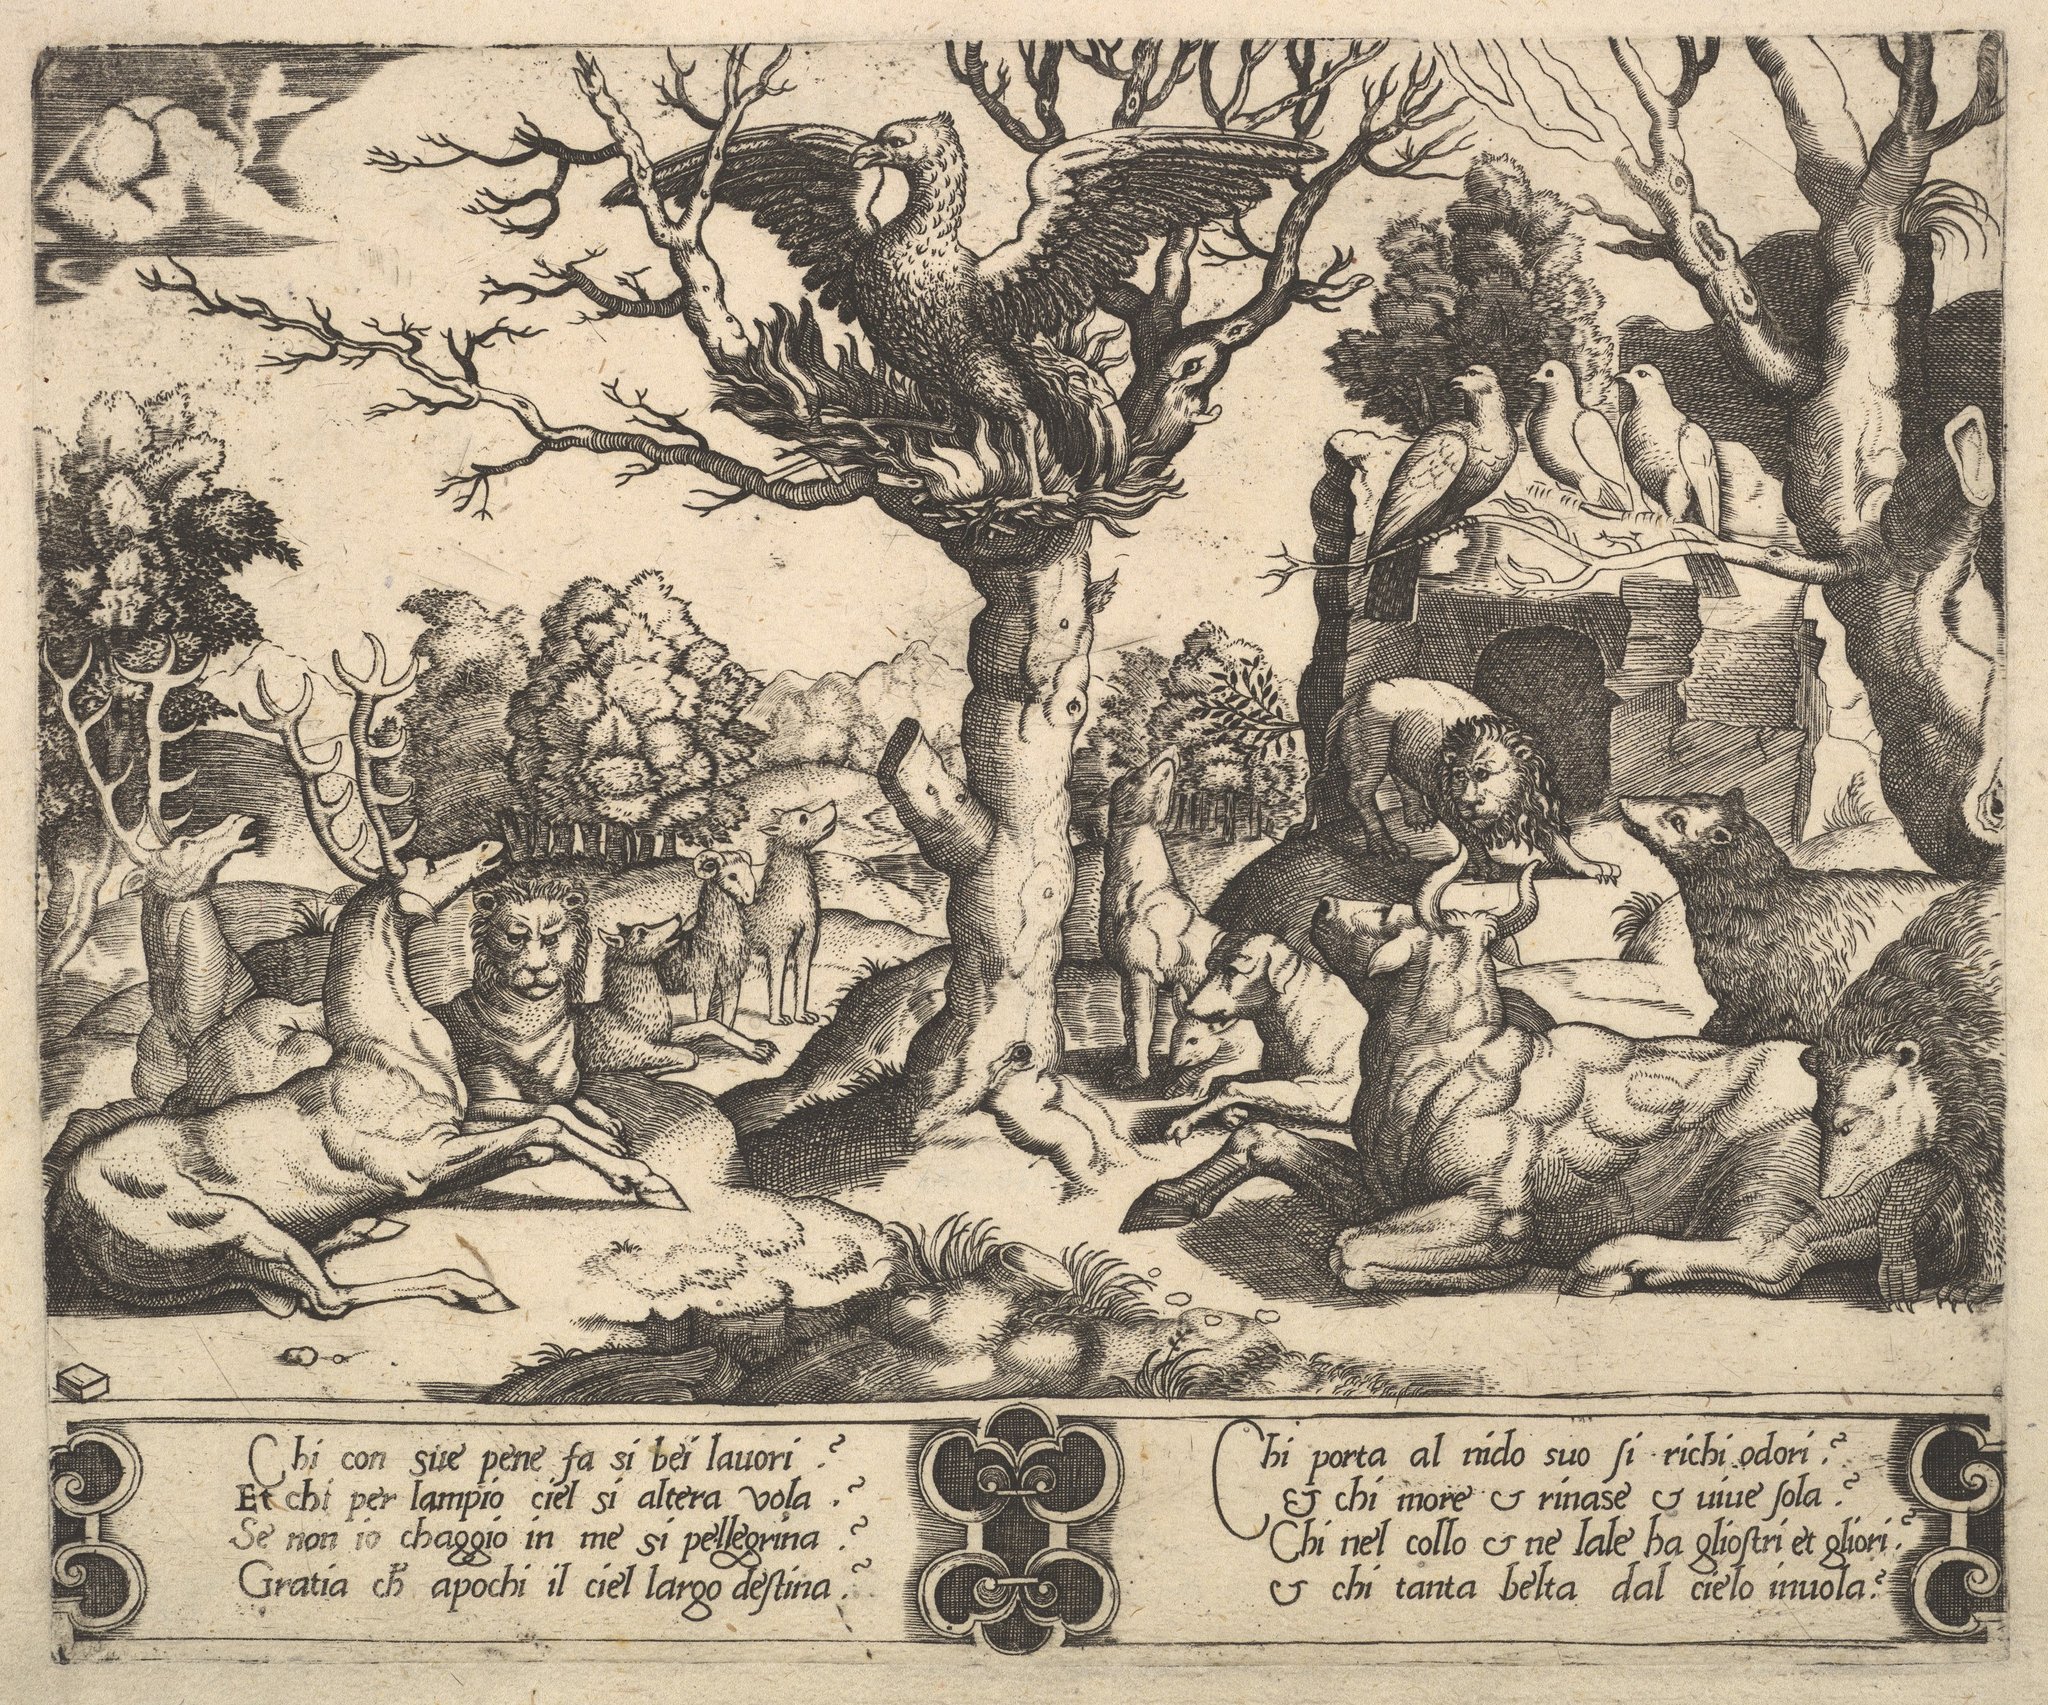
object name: print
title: A phoenix sat atop a tree, wings open, an assortment of animals below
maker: master of the die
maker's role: artist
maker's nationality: italian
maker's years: 1525-1560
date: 1530-1560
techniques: engraving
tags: birds,bulls,lions